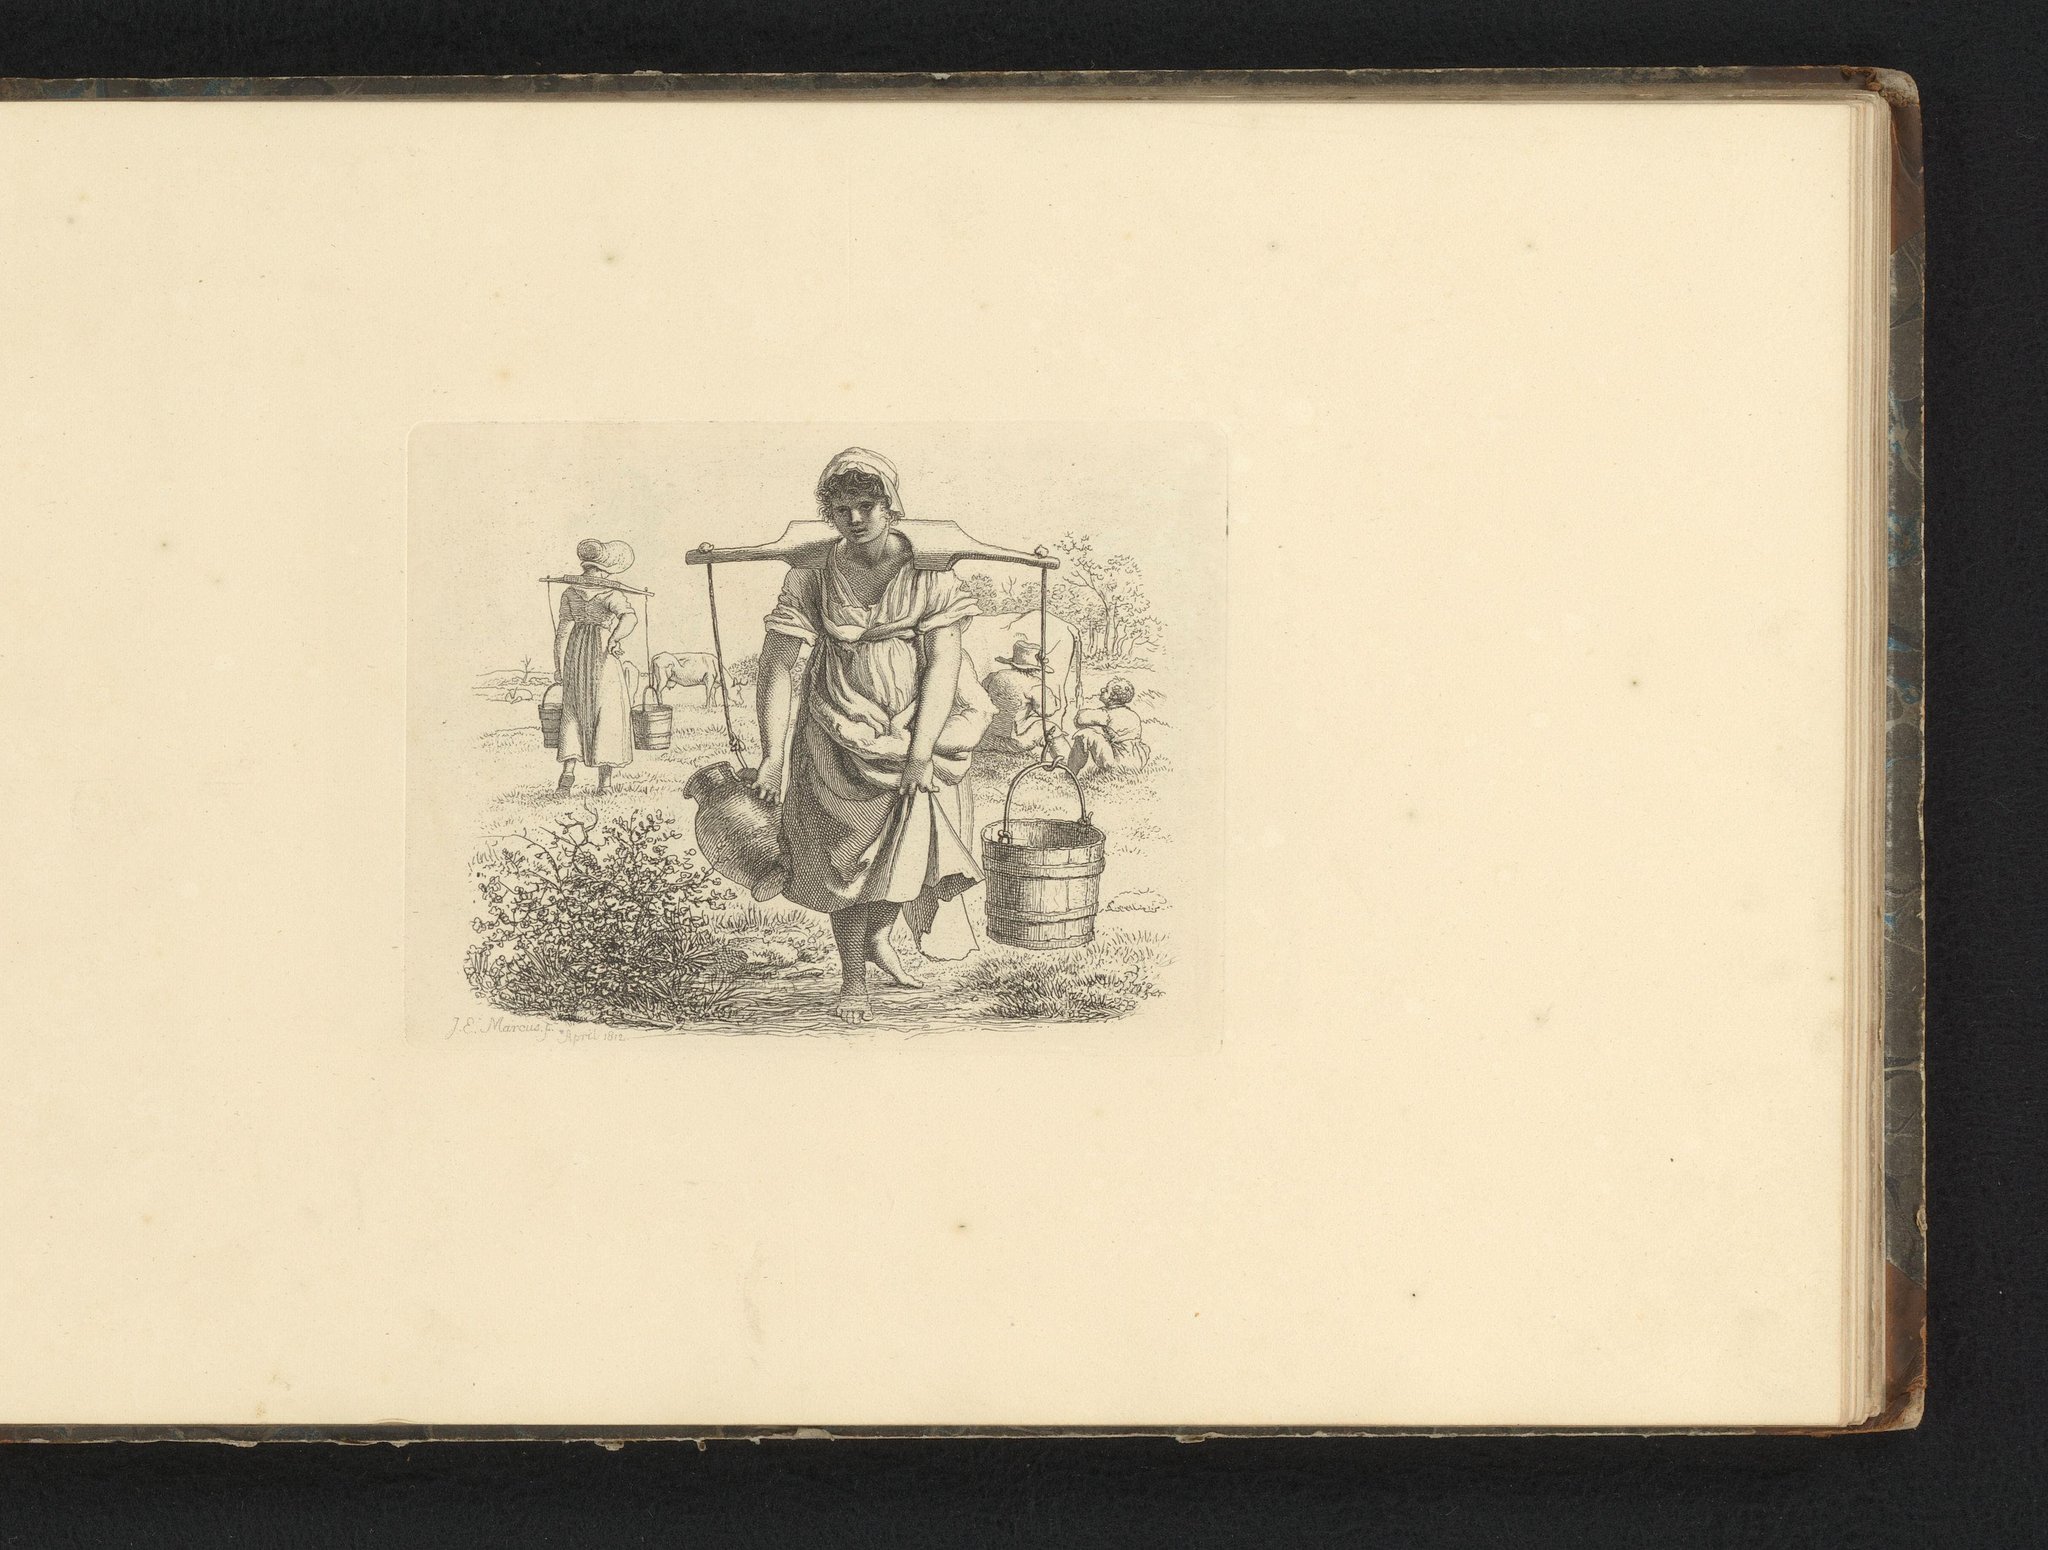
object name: print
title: Twee jonge vrouwen met melkemmers aan juk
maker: jacob ernst marcus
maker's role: draughtsman, print maker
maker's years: 1774-1826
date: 1804-1812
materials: paper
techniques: etching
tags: cow, carrying something with yoke, milkmaid, milking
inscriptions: date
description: Op de achtergrond melkt een boer terwijl een jongen toekijkt. Deze prent maakt deel uit van een album.